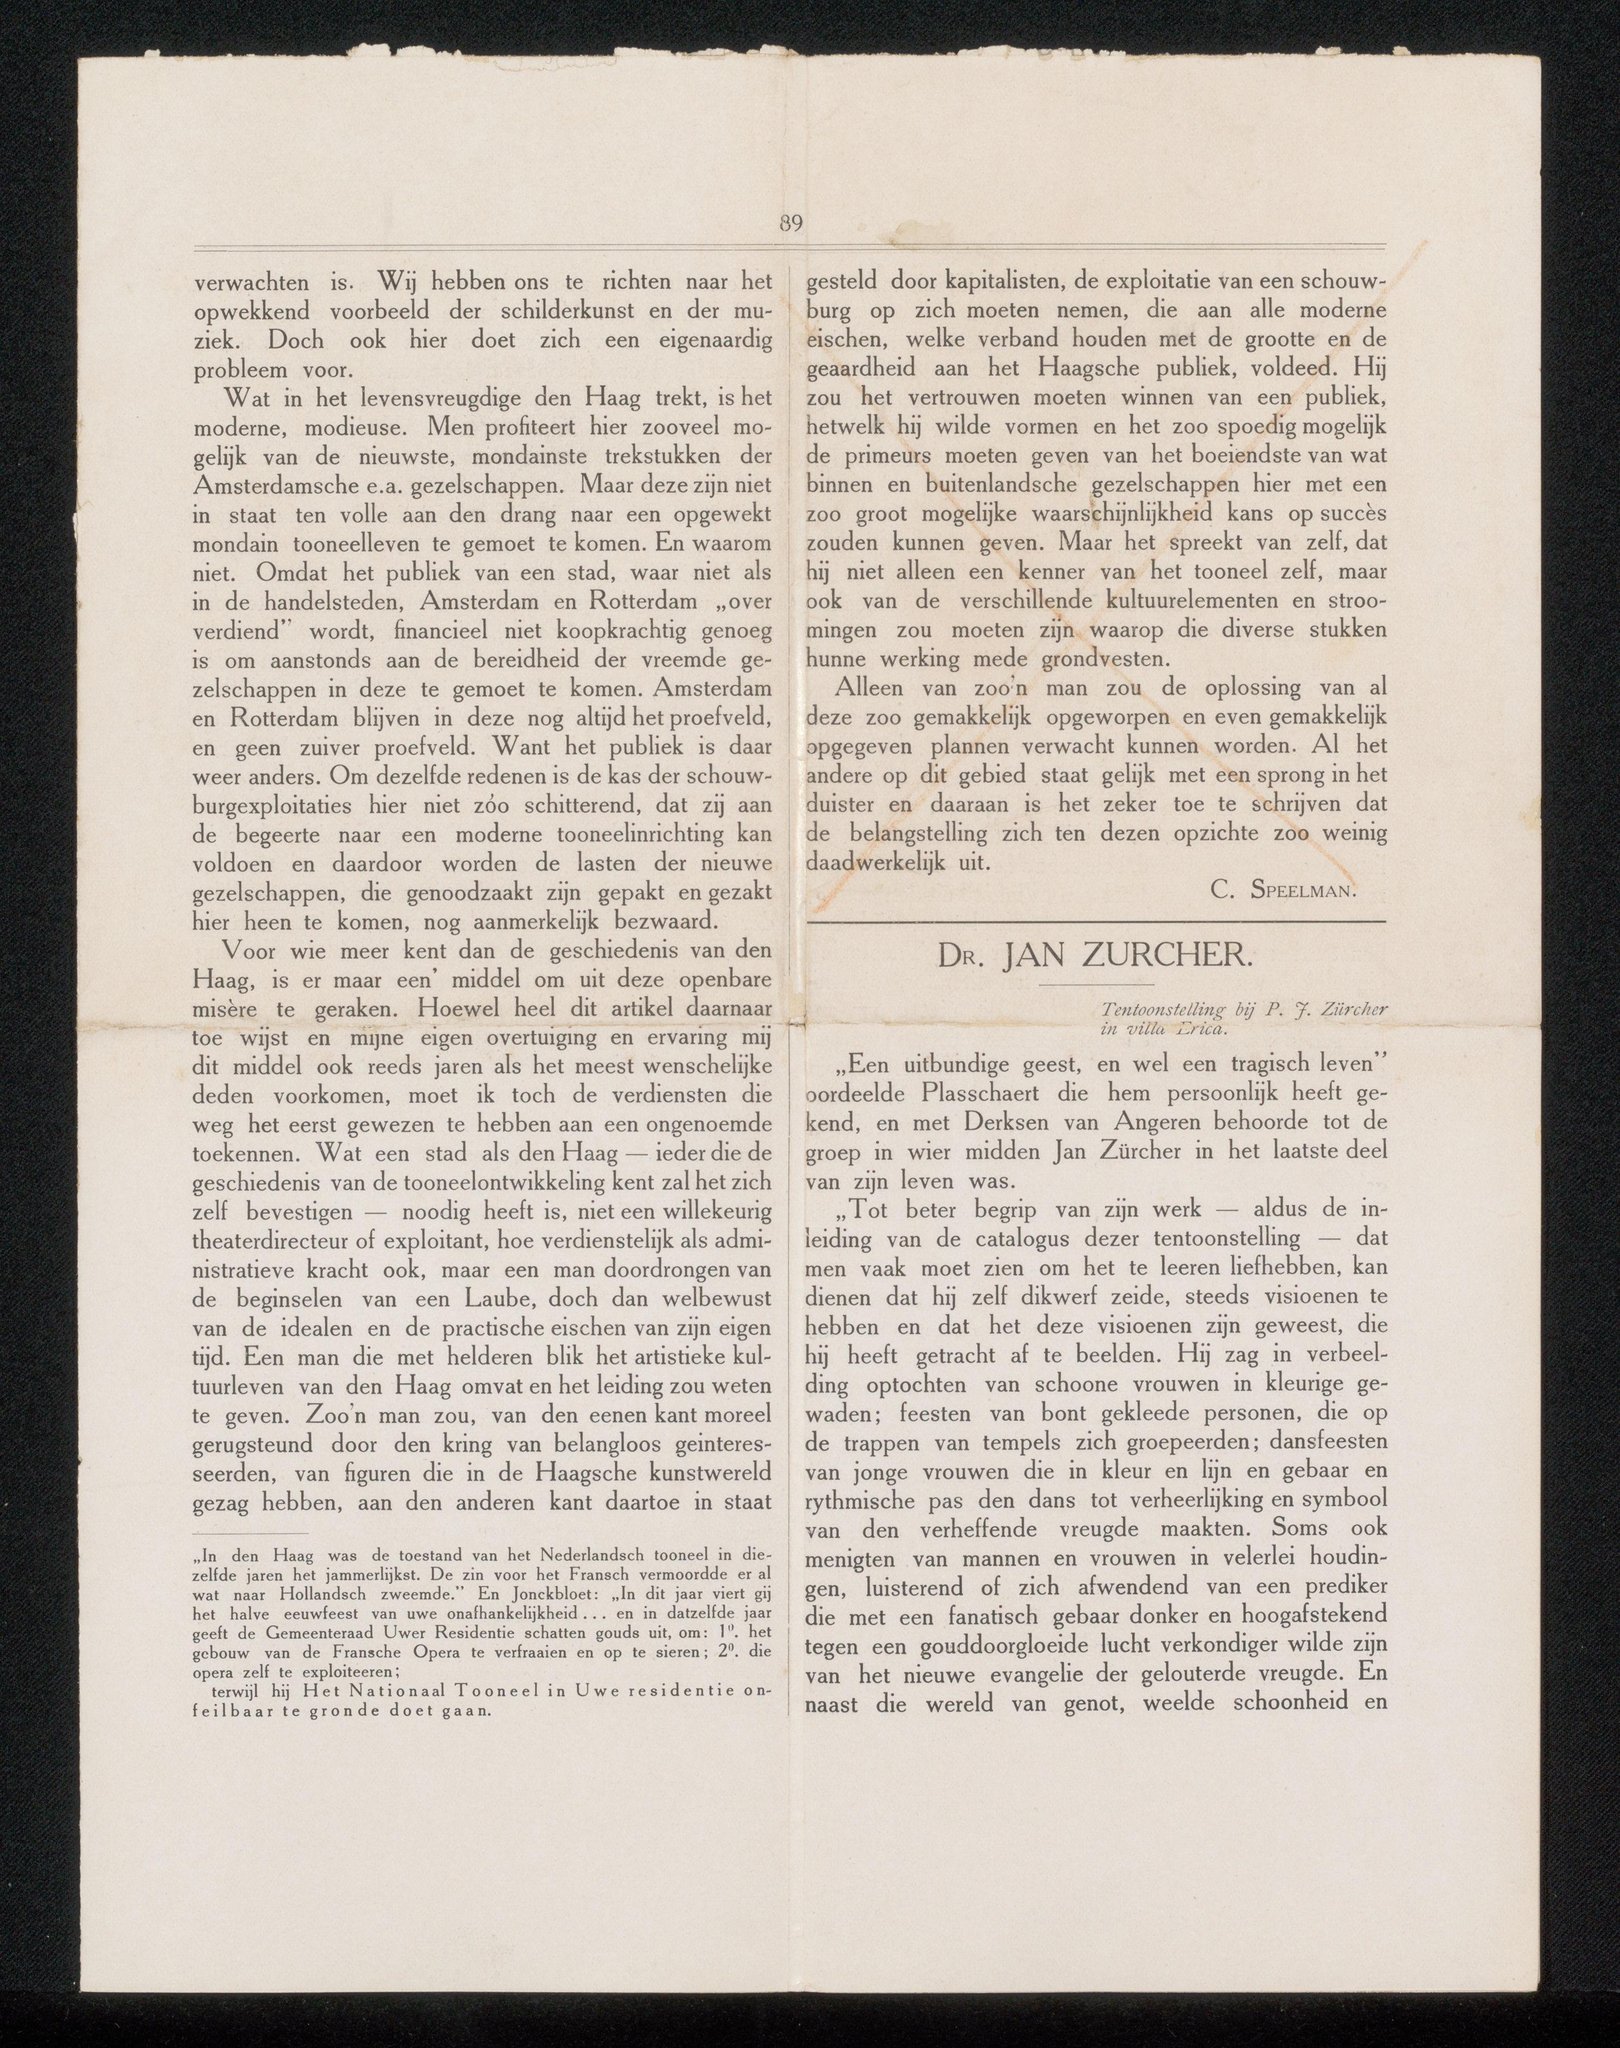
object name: article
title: Artikel uit archief Philip Zilcken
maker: Anonymous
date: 1905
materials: paper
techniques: printing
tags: jan zürcher, publisher, p.j. zürcher, the hague, painter, draughtsman, philip zilcken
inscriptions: collector's mark: ‘RPK’